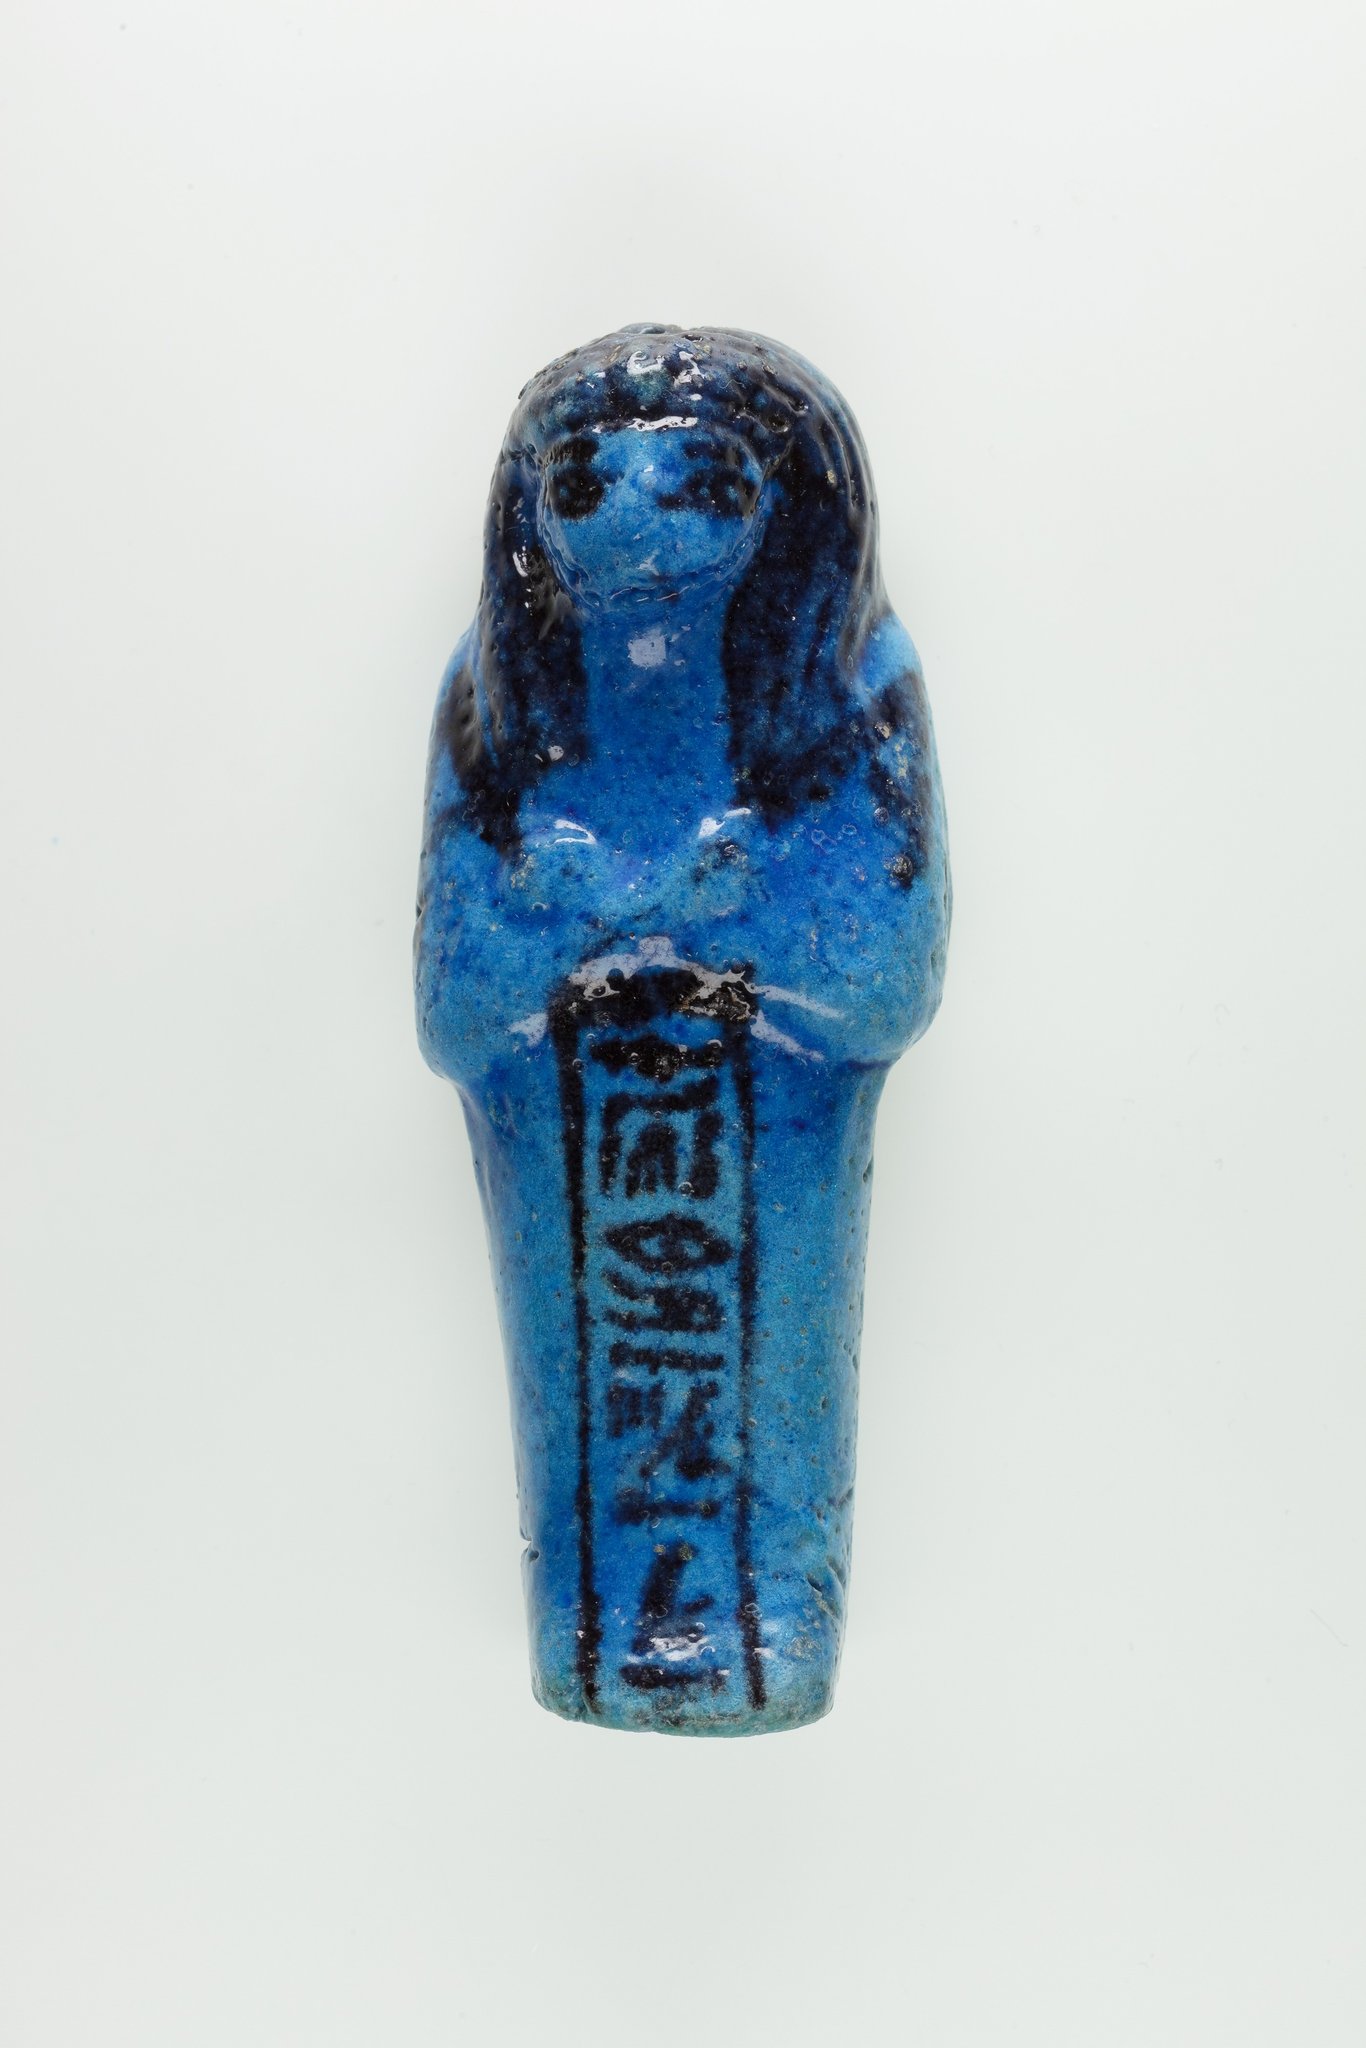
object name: shabti, worker, nauny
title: Worker Shabti of Nauny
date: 1050 BCE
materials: faience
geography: egypt